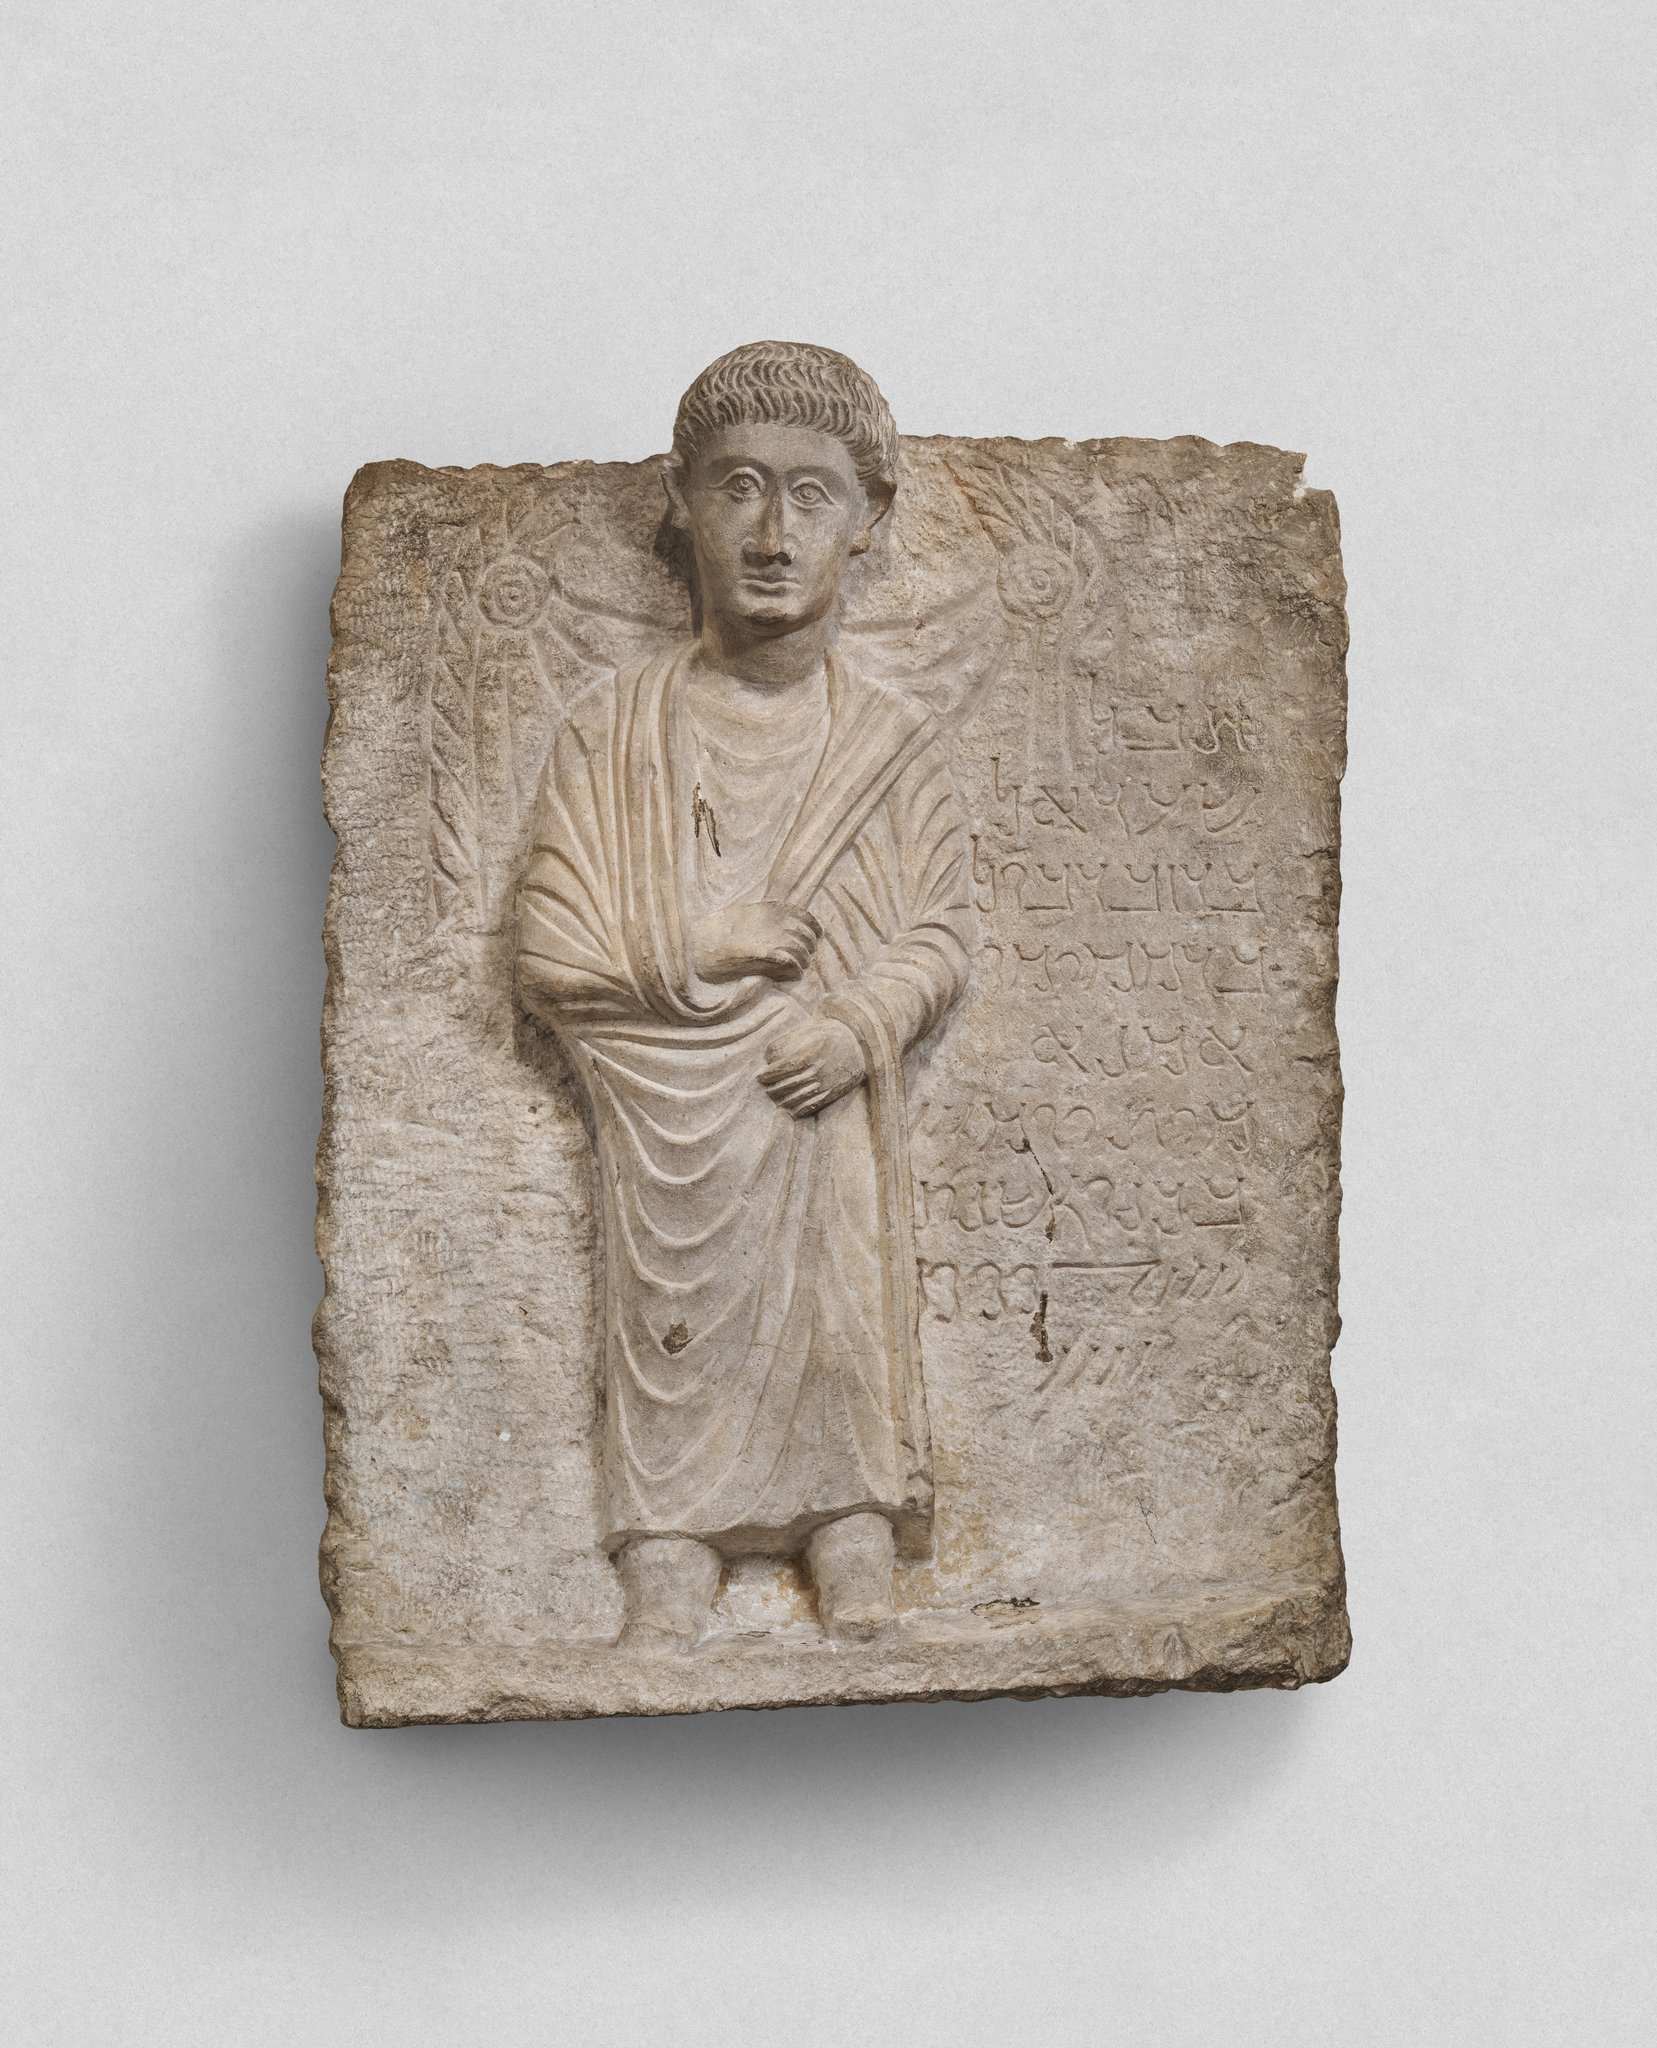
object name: funerary relief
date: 172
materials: limestone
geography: syria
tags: men